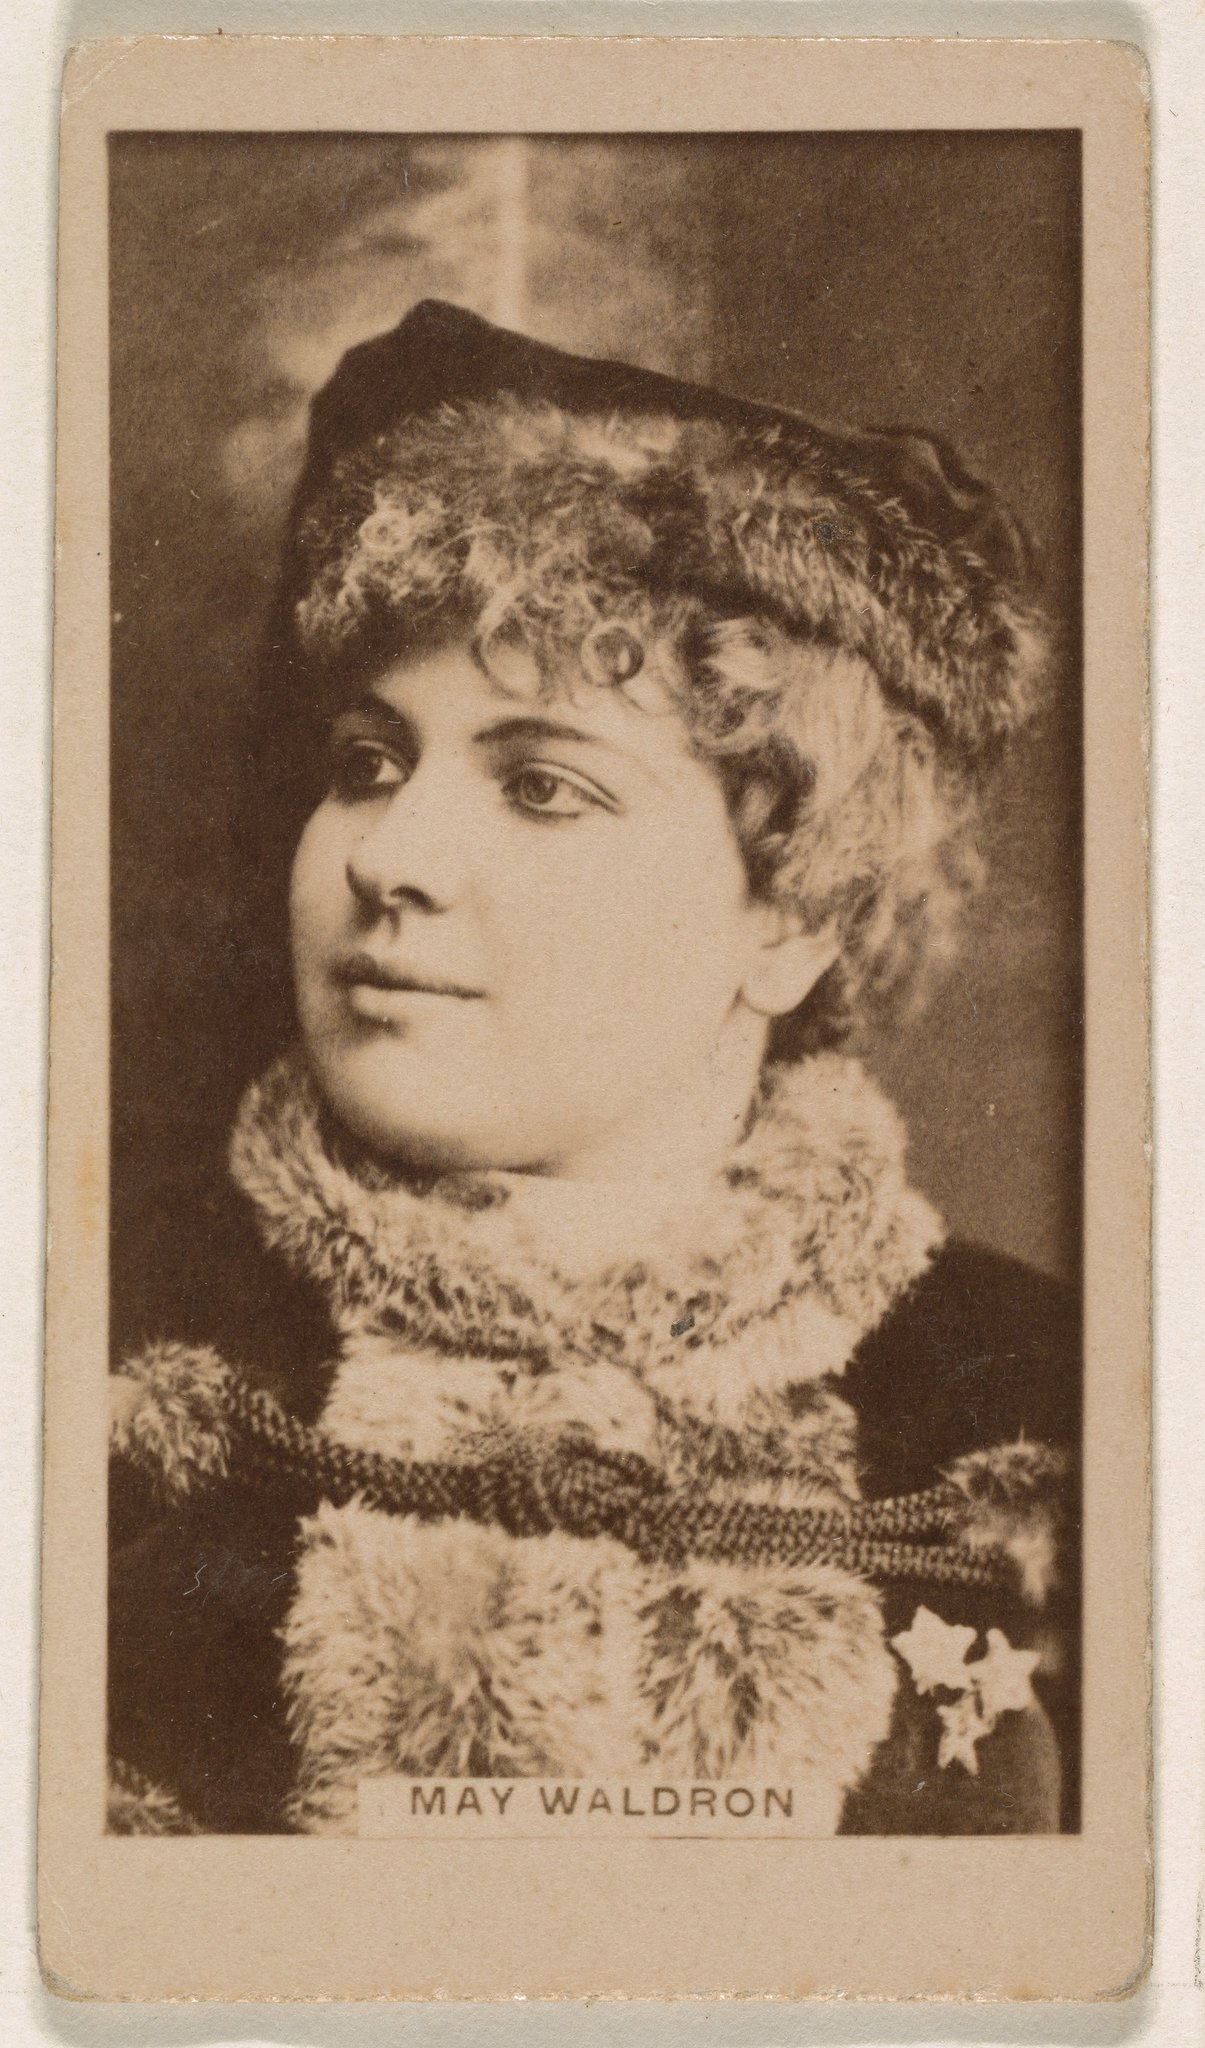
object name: photograph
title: May Waldron, from the Actresses series (N245) issued by Kinney Brothers to promote Sweet Caporal Cigarettes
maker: kinney brothers tobacco company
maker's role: publisher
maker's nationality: american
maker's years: 1869-2011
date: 1890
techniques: albumen silver print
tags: portraits,women,actresses